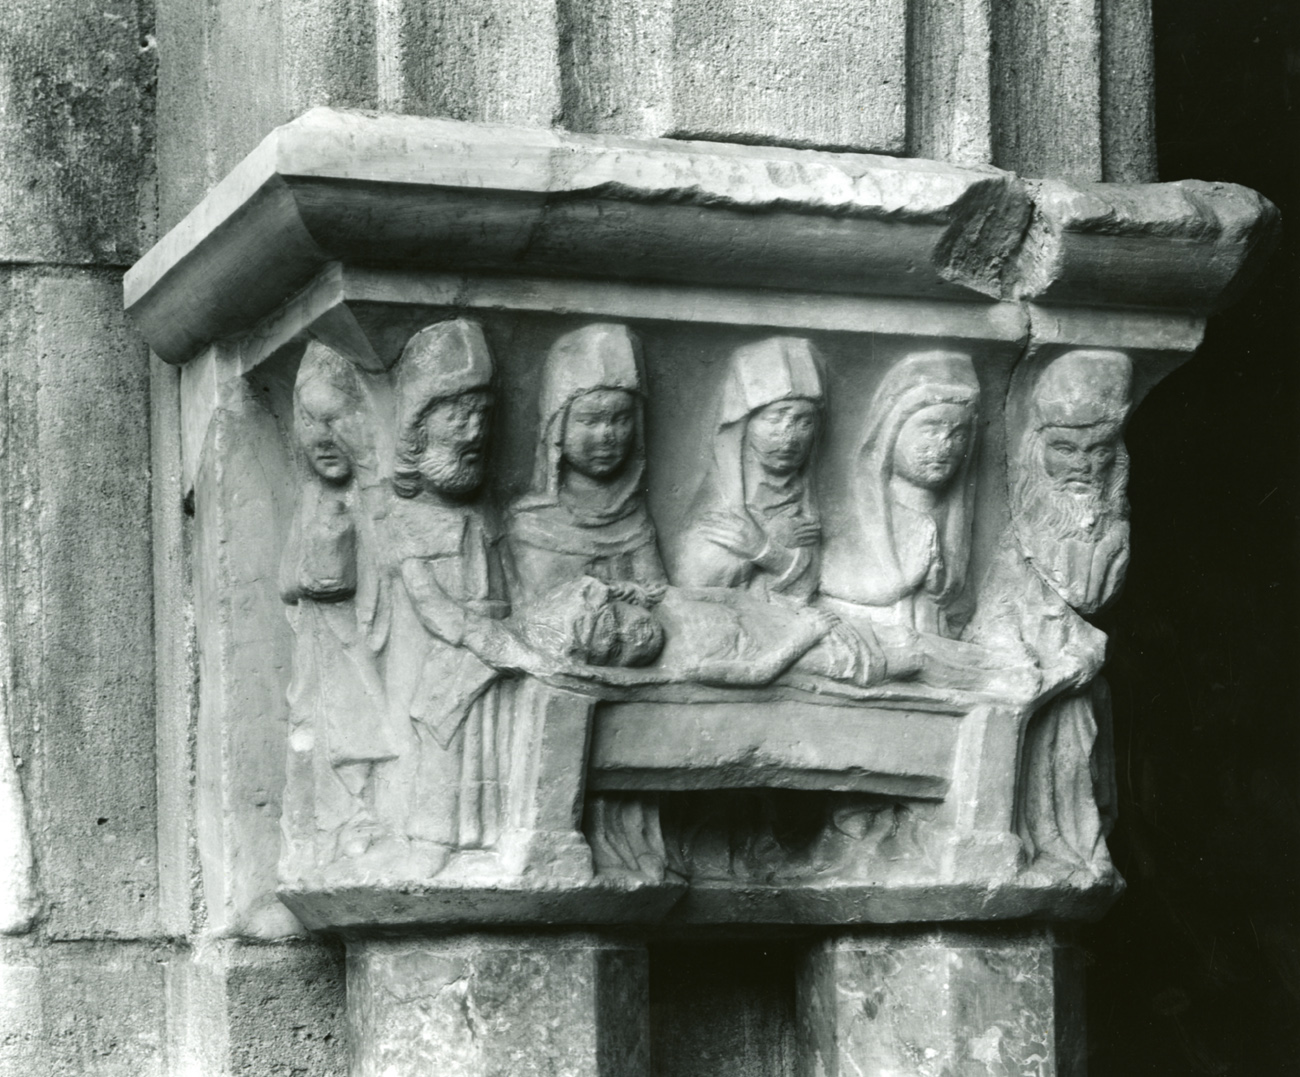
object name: capital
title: Engaged Double Capital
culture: french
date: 1467-1500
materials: marble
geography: france